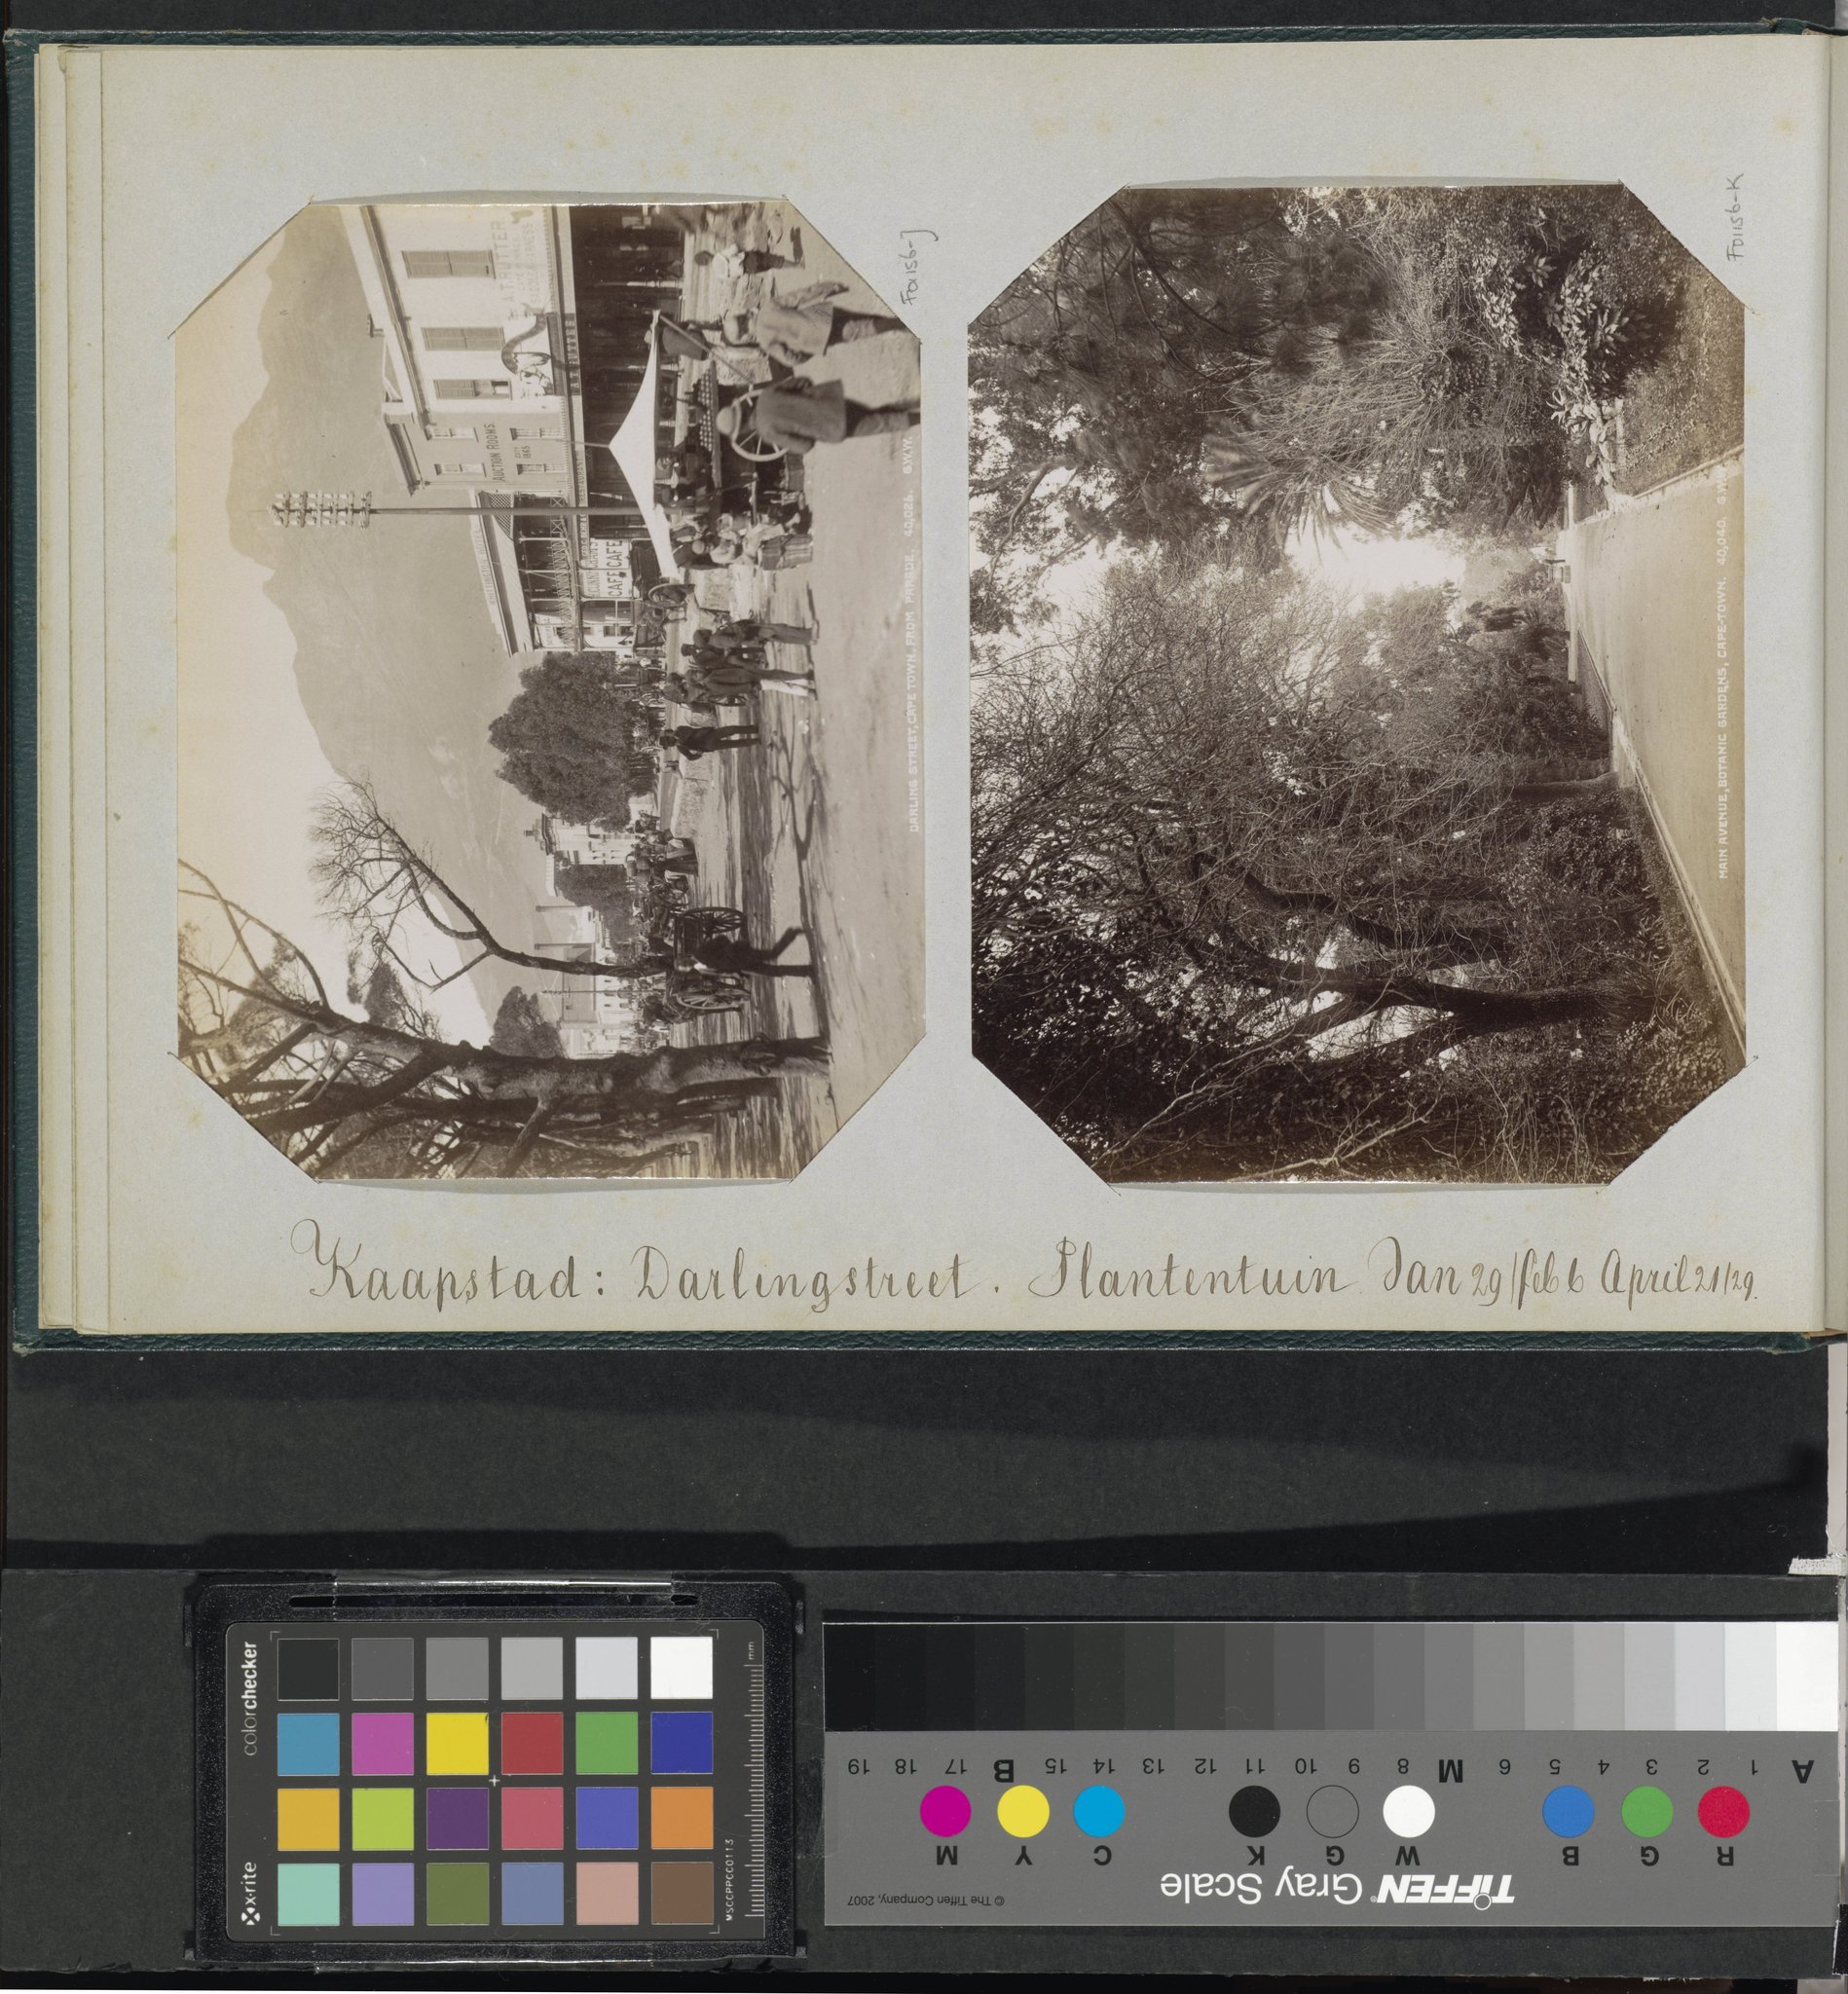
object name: photograph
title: Gezicht op de botanische tuin te Kaapstad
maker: george washington wilson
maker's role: publisher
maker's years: 1823-1893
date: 1870-1893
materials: photographic support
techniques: albumen print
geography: cape town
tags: botanic garden, 'hortus botanicus'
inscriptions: annotation: ‘Kaapstad: Darlingstreet. Plantentuin Jan 29/feb 6 April 21/29’, inscription: ‘Main Avenue, botanic gardens, Cape-Town. 40,040. G.W.W.’